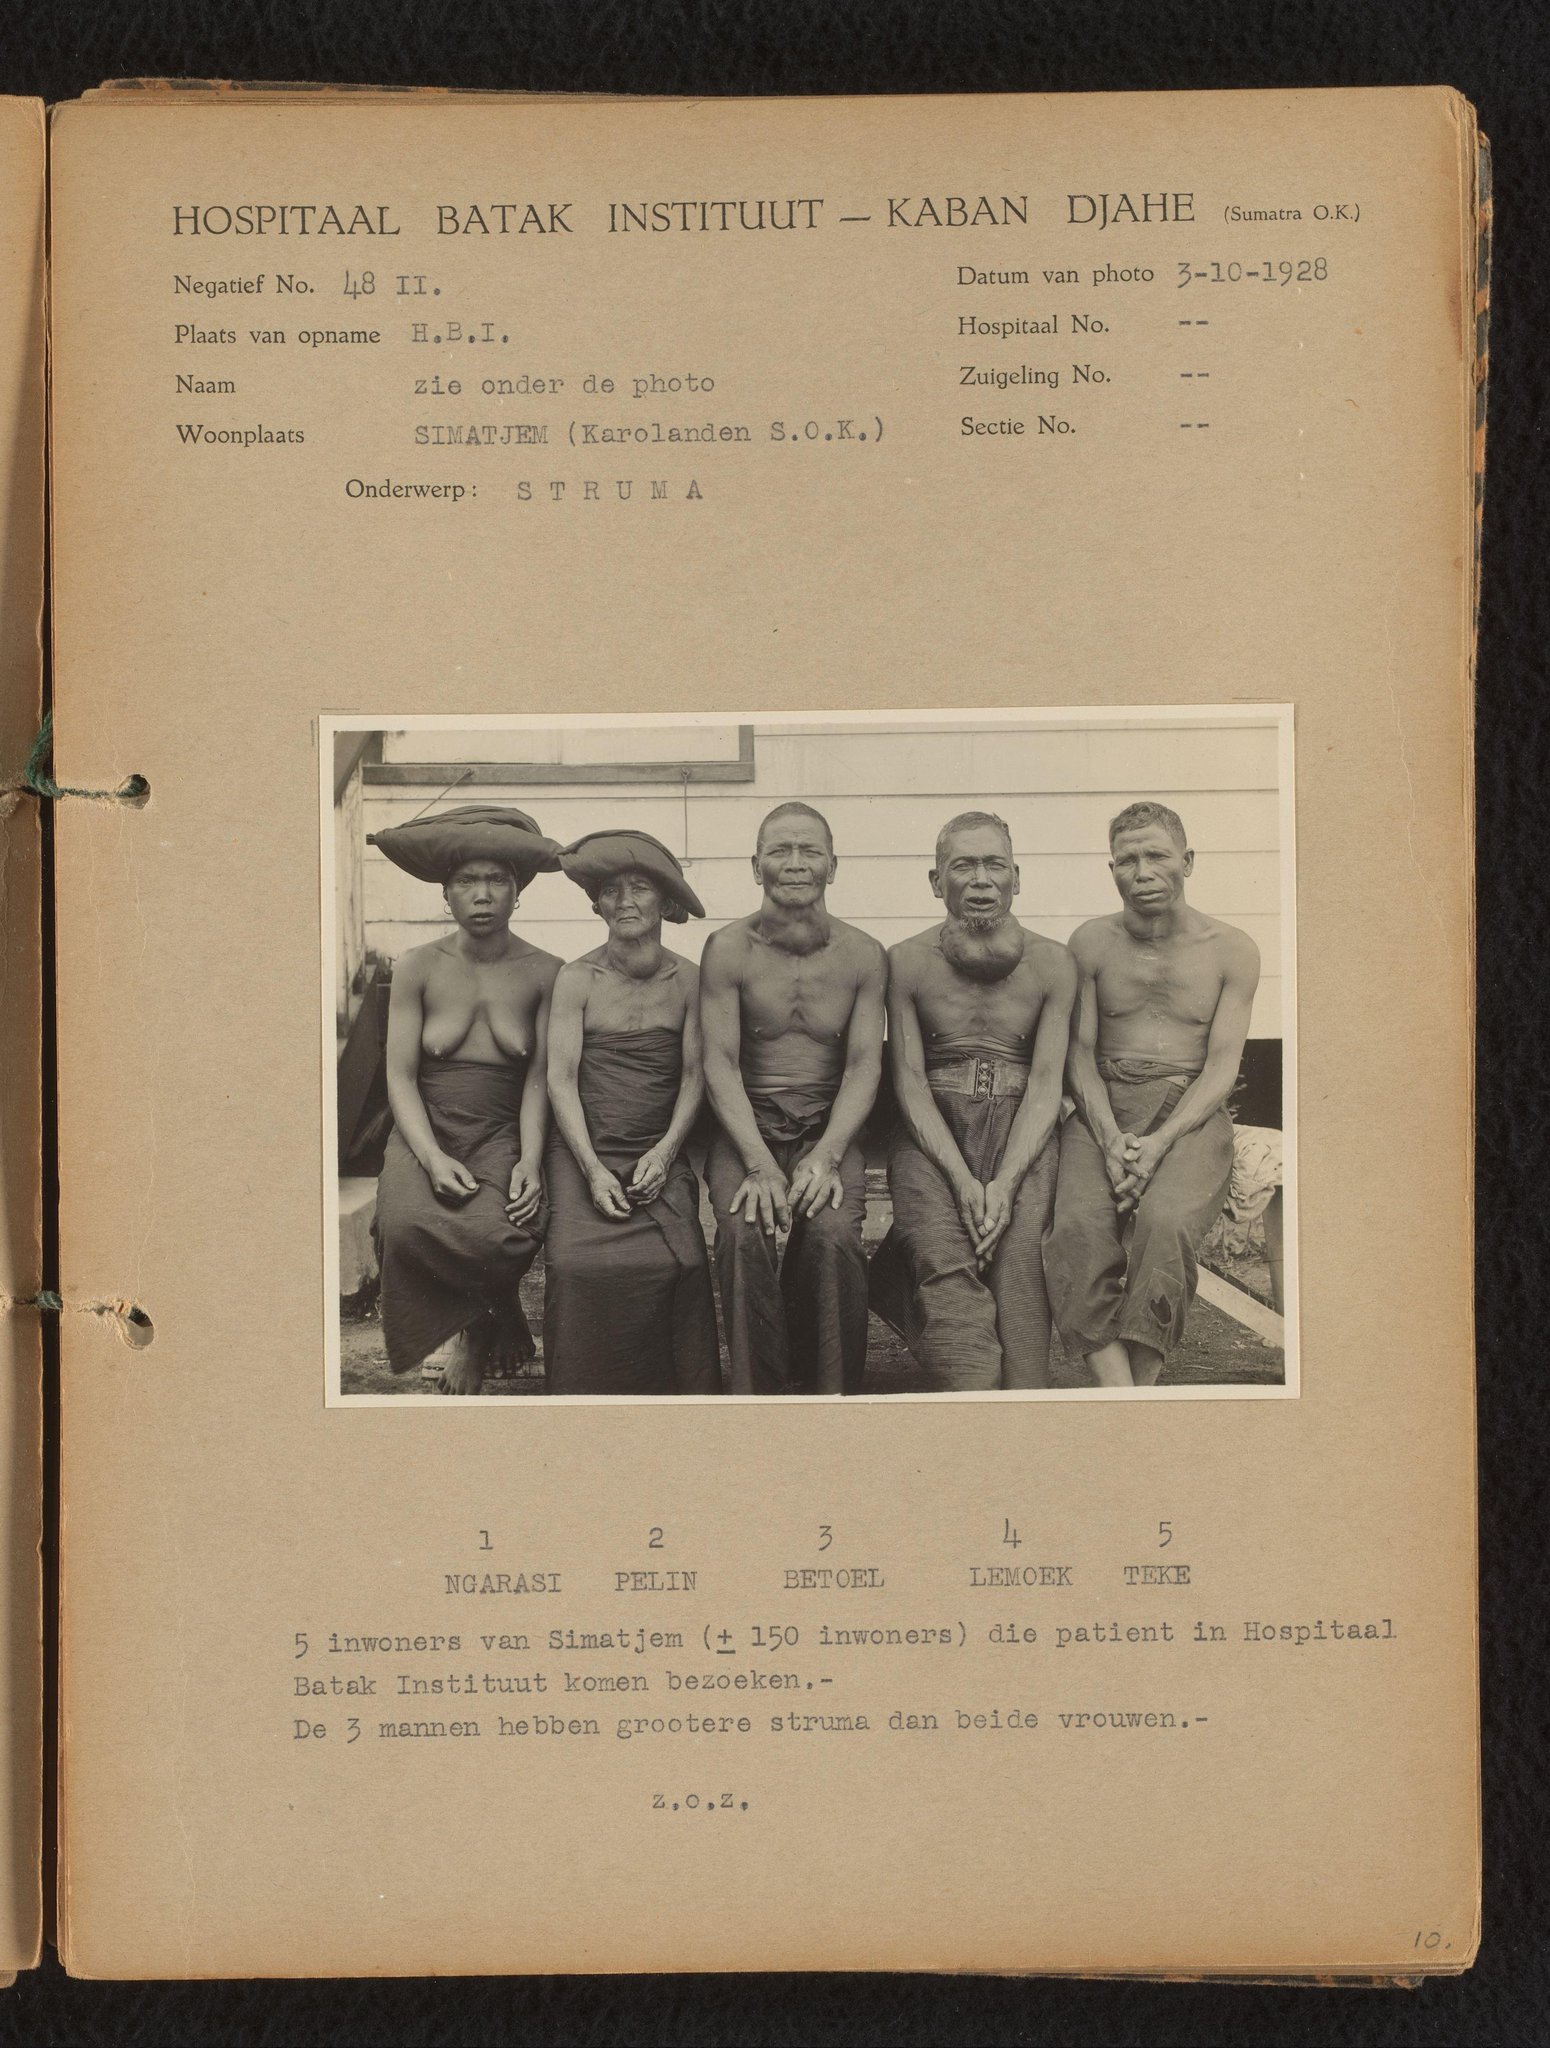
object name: photograph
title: Vijf patiënten met struma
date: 1928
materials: cardboard, photographic support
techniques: gelatin silver print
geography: kabanjahe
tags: colonial system, patient, sick person, sumatra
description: Medische foto van twee vrouwelijke en drie mannelijke patiënten met de aandoening struma of krop. Datum foto: 3 oktober 1928. Foto geplakt op voorgedrukt kartonnen blad ingebonden in het fotoalbum over het Hospitaal Batak Instituut te Kabanjaheh op Sumatra in de jaren 1926-1929.